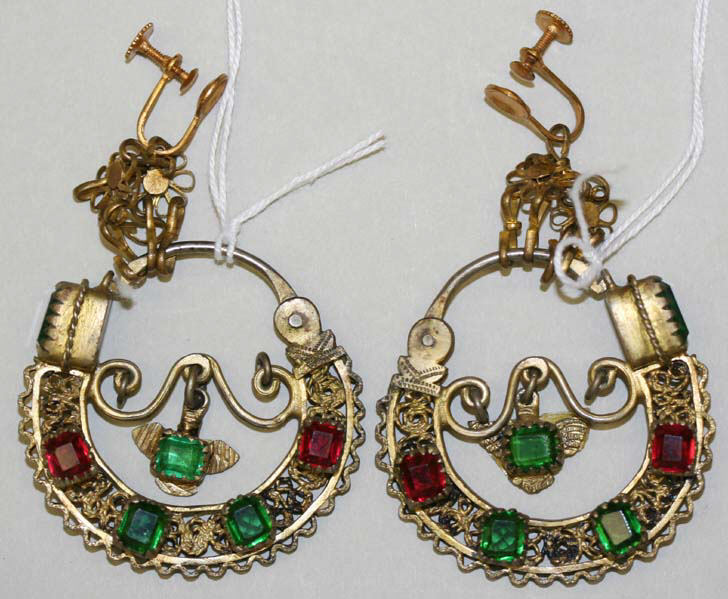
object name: earring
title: Earrings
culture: spanish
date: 1801-1900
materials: glass, metal